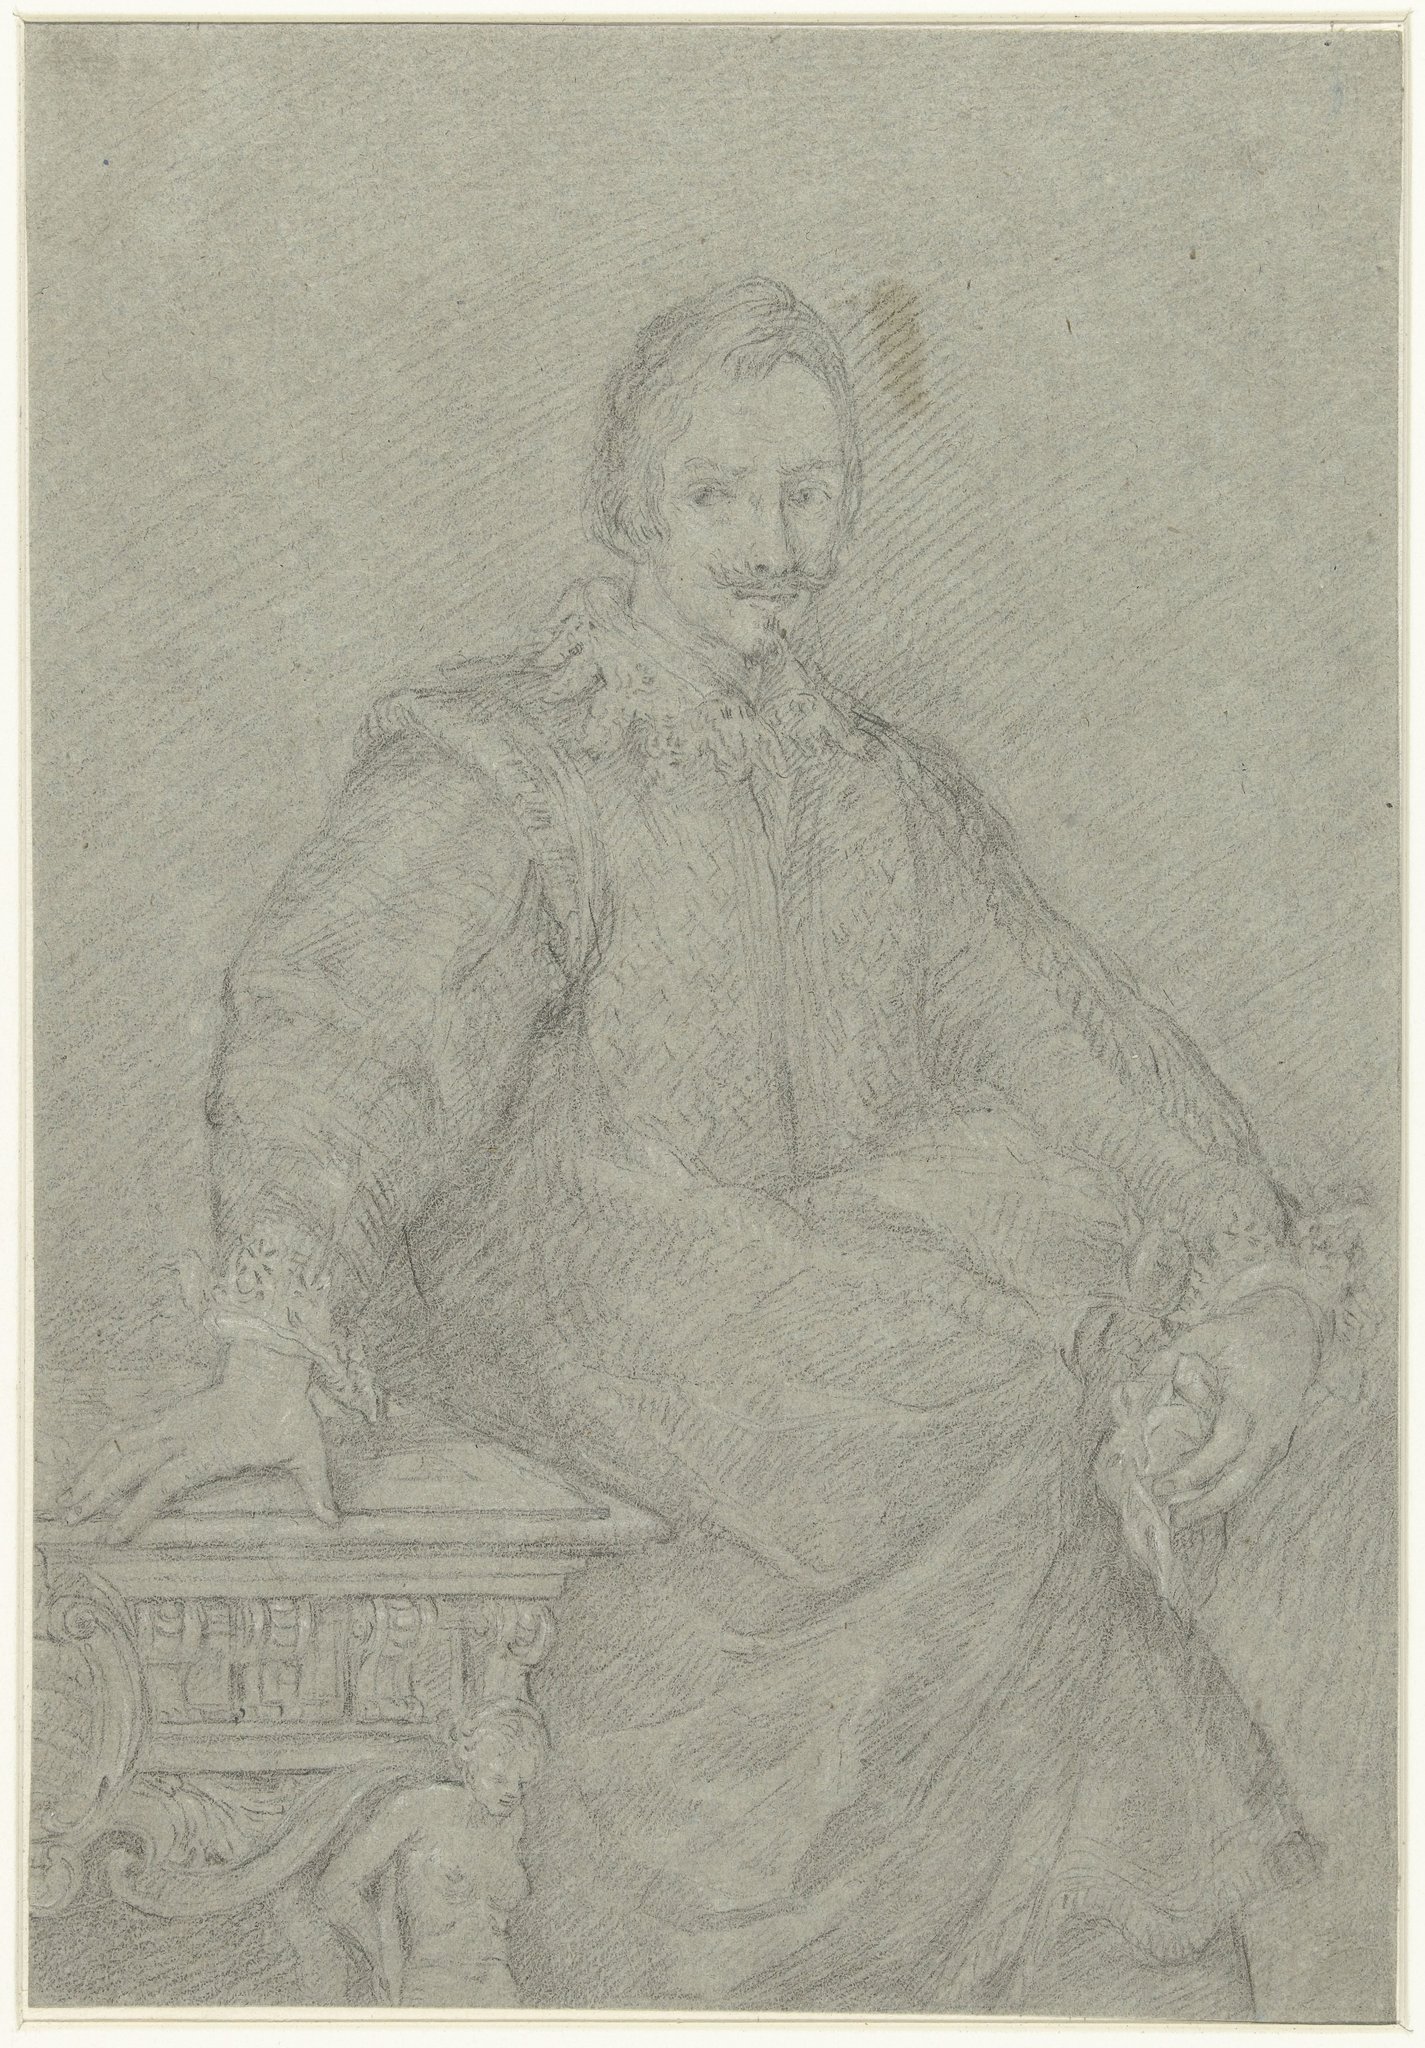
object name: drawing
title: Portret van een onbekende staande man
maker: Anonymous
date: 1600-1699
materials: chalk, paper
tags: standing figure, anonymous historical person portrayed alone, male sex; man